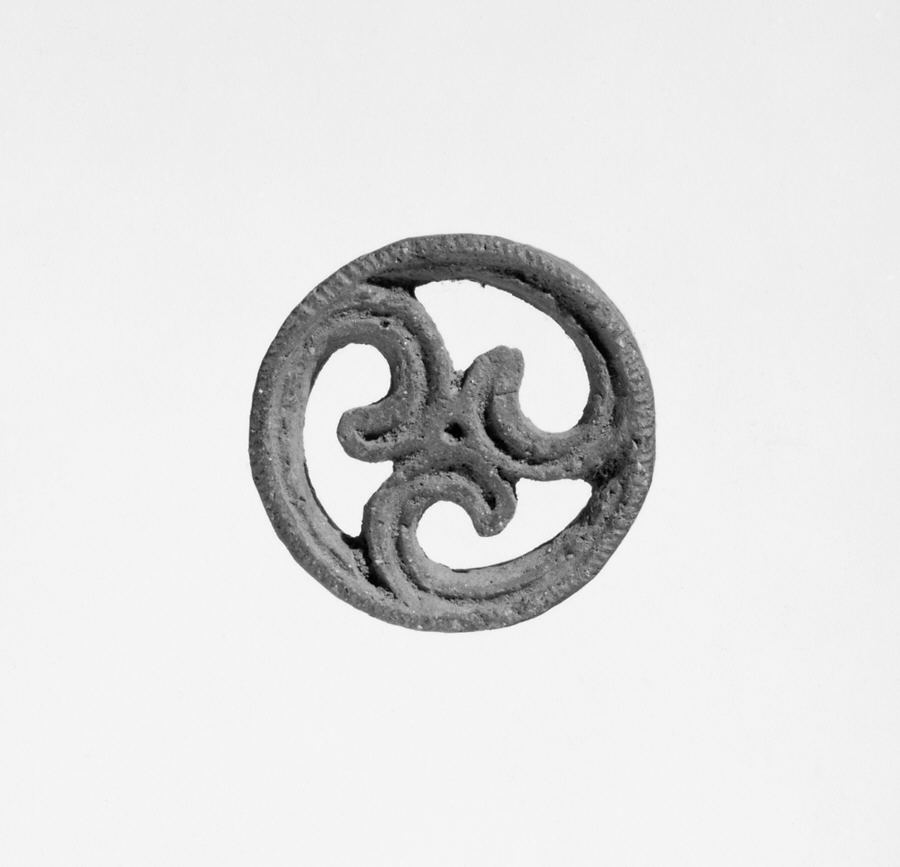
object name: earring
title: Pulley-Shaped Earrings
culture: japanese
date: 1000-200 BCE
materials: earthenware